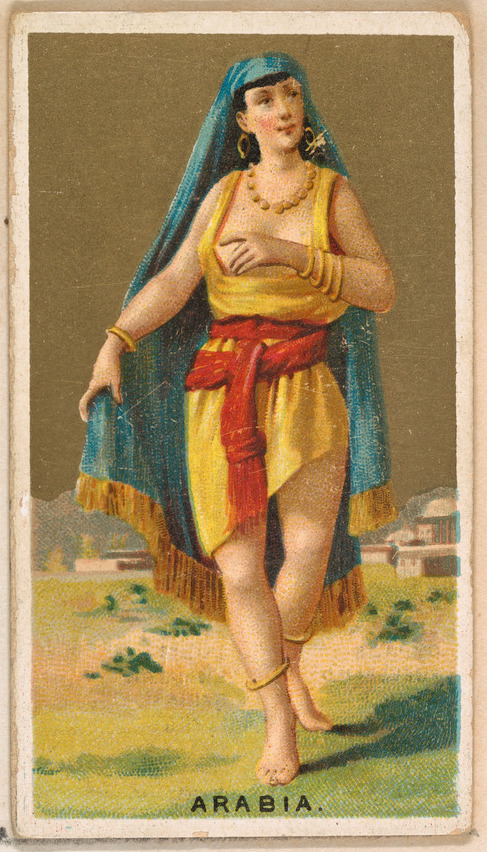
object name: print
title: Arabia, from the Dancing Girls of the World series (N185) issued by Wm. S. Kimball & Co.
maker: william s. kimball & company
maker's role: publisher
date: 1889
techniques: color lithograph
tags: women,dancing